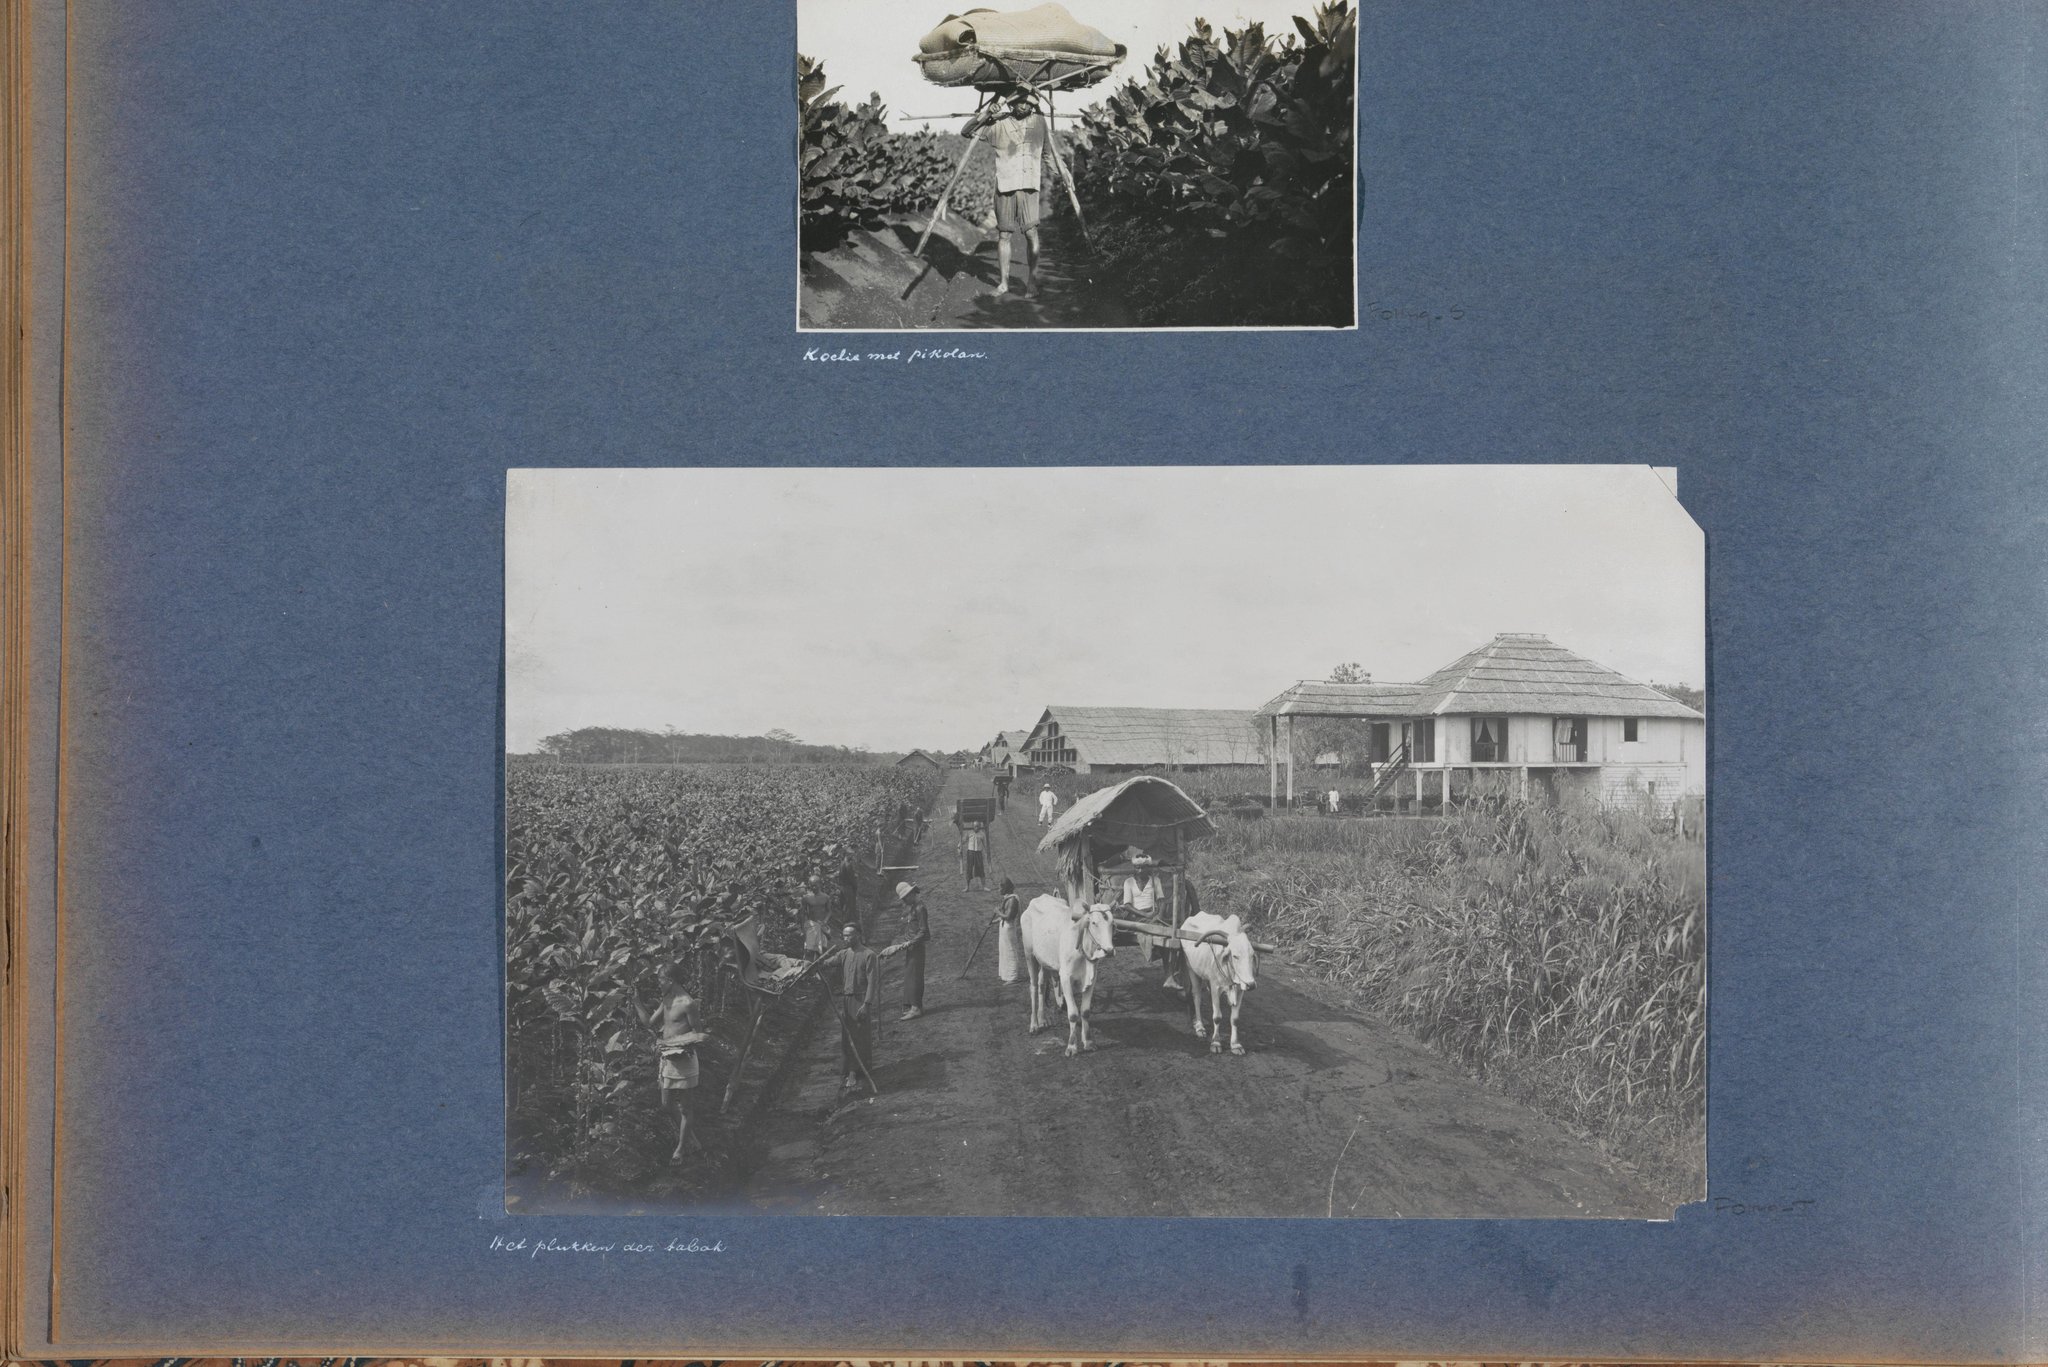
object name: album leaf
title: Planten van tabak met ossenwagen op een plantage op Sumatra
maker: carl j. kleingrothe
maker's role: fotograaf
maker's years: 1864-1925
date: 1900-1915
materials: paper, photographic support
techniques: gelatin silver print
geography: sumatra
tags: plantation, barn, rural housing, e.g. country-house, villa, cottage, ox, tobacco, sumatra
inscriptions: name: ‘Kleingrothe O.K.v.Sumatra’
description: Onderdeel van reisalbum met foto's van bedrijvigheid en bezienswaardigheden op Sumatra en Java en van de reis naar en van Nederlands-Indië.